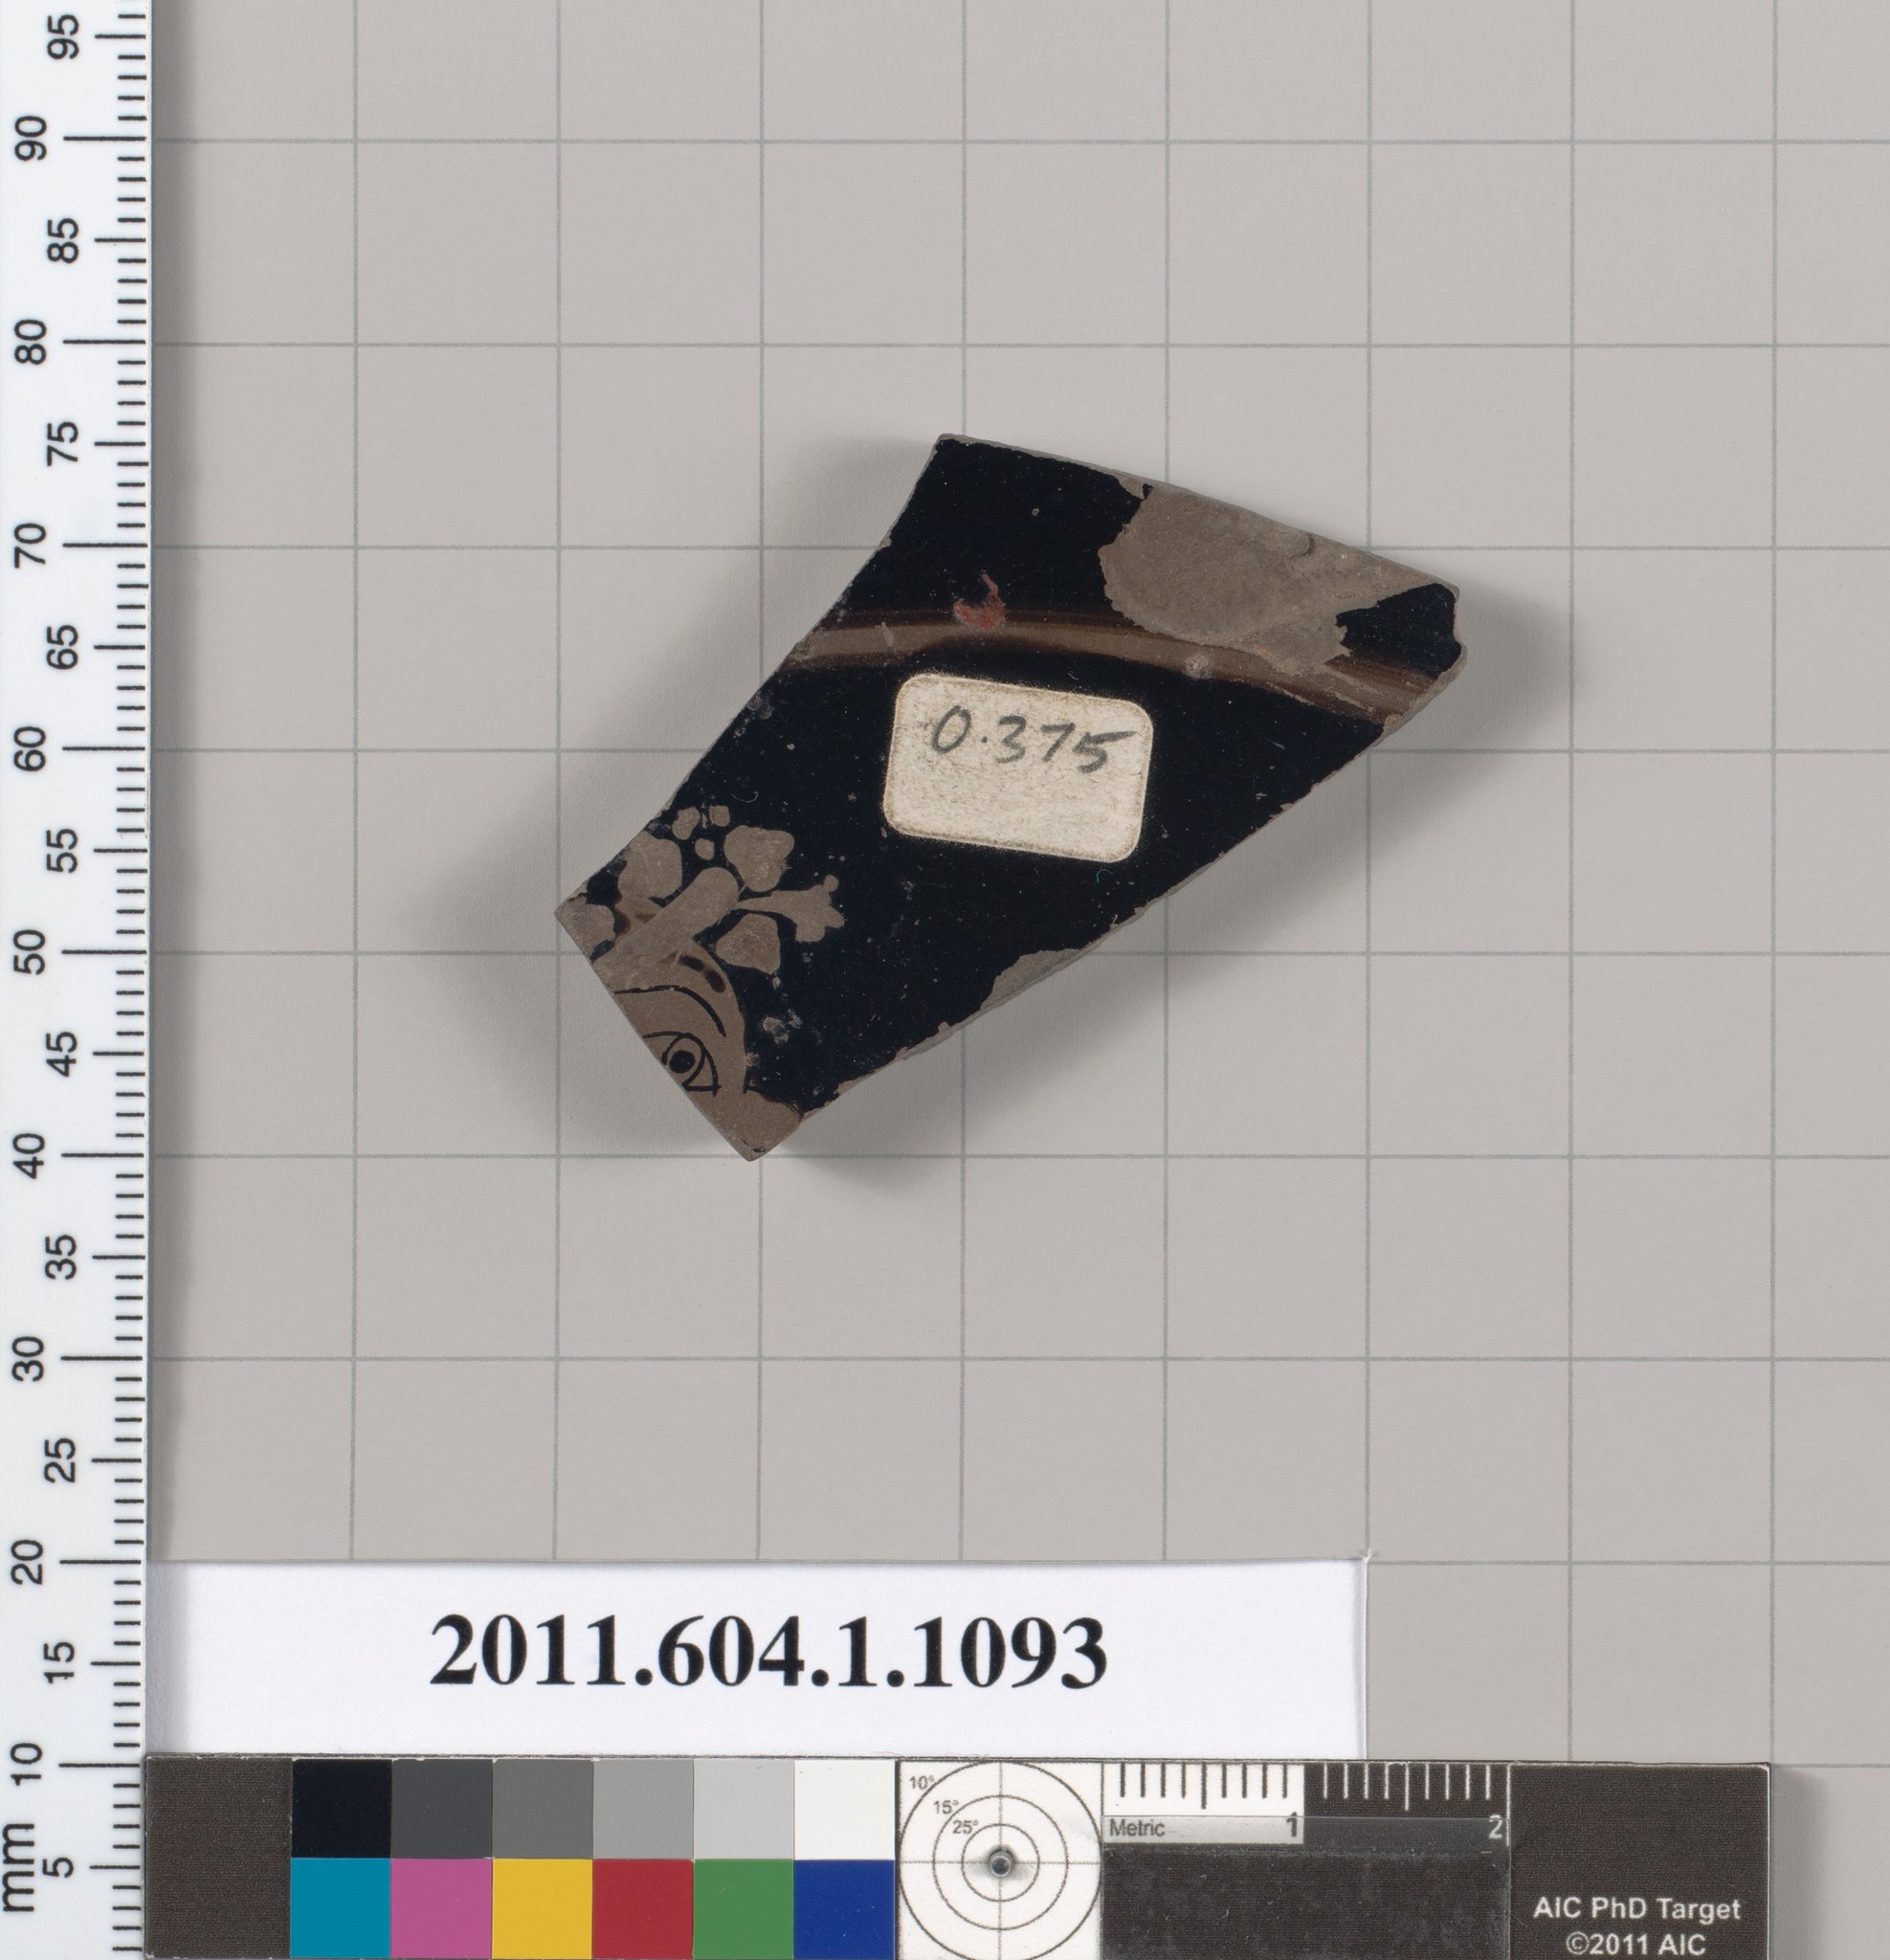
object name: kylix fragment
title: Terracotta fragment of a kylix (drinking cup)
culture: greek, attic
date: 520-500 BCE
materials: terracotta